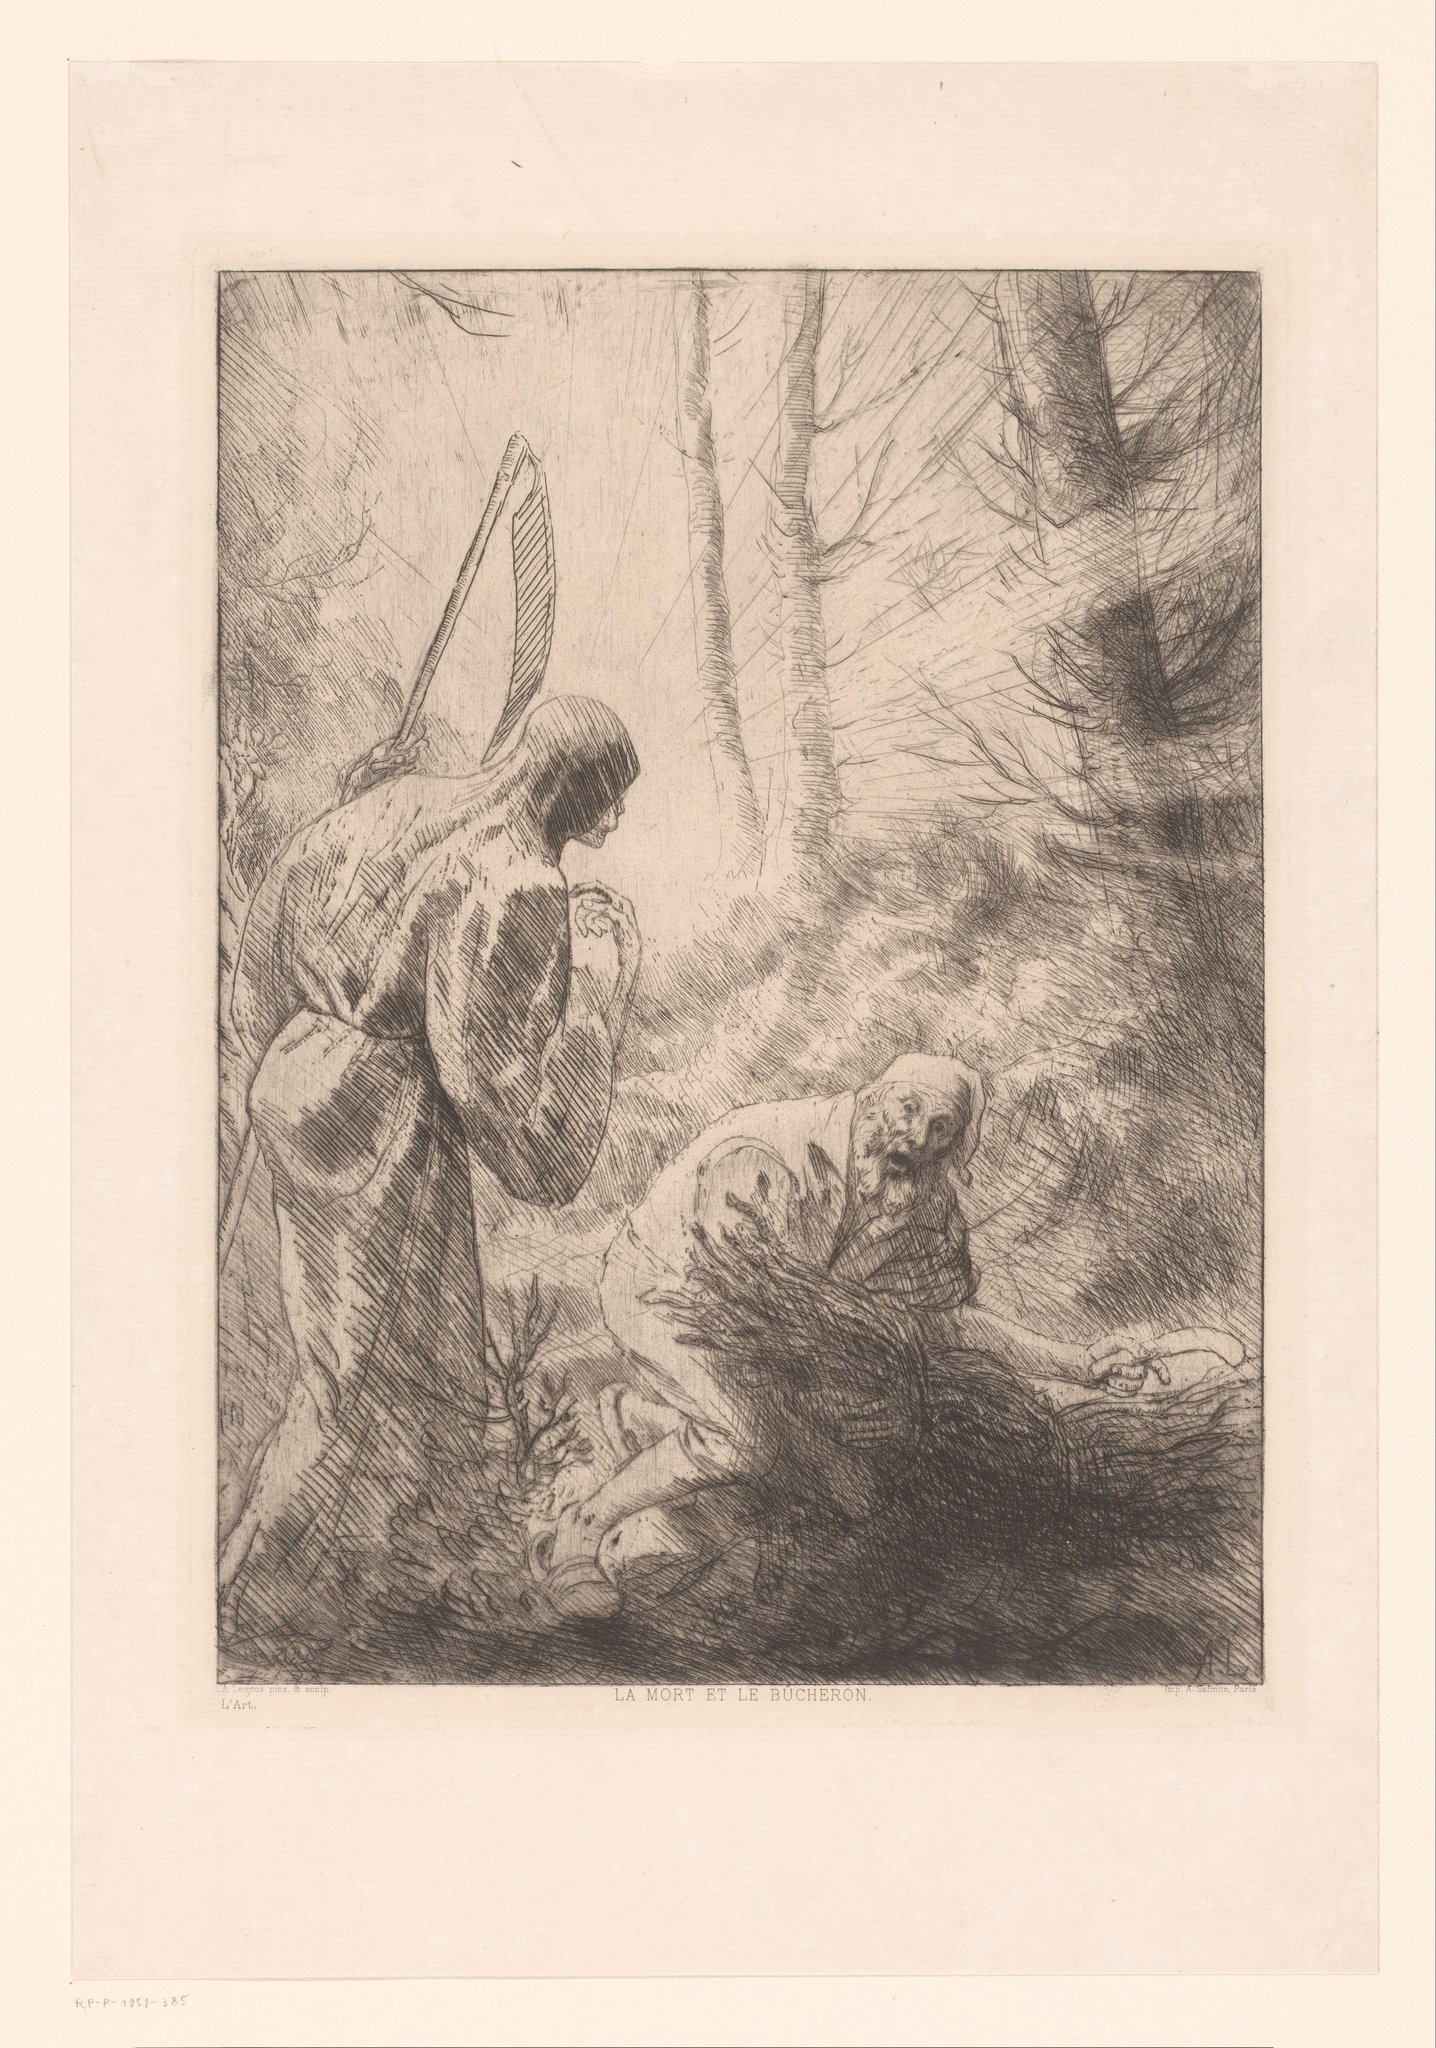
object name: print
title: La mort et le bûcheron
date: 1879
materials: paper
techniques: drypoint, engraving, etching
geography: france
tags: death as man, old man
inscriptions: collector's mark: Lugt 2228